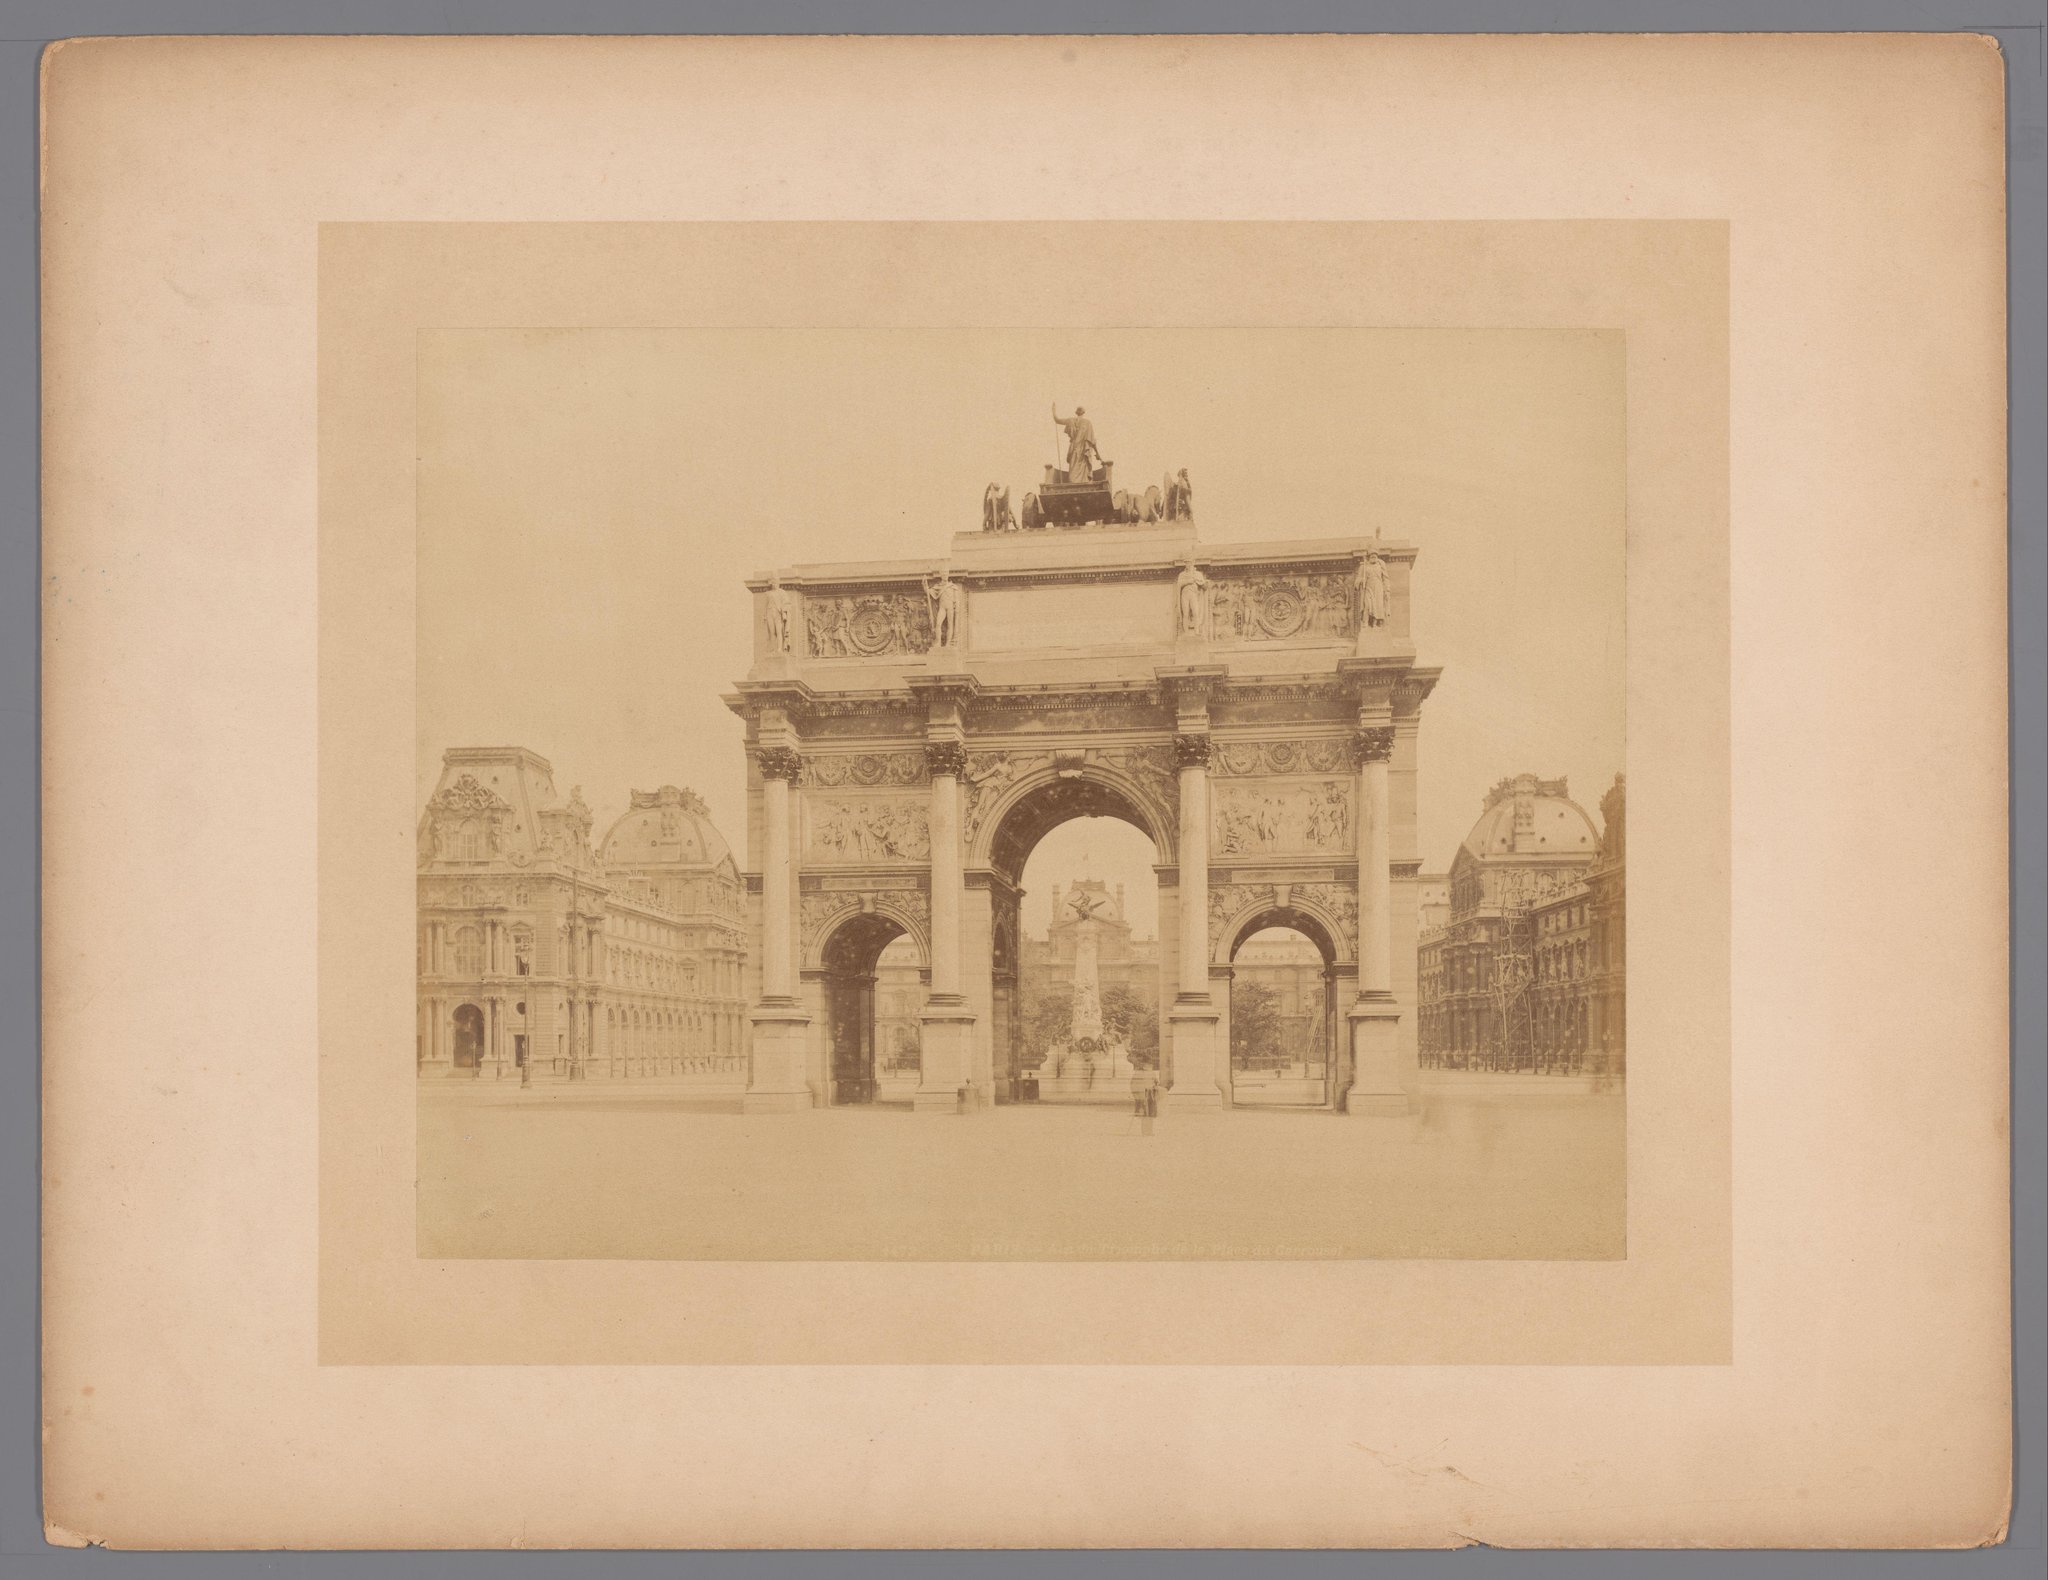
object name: photograph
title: Arc de Triomph vanuit het Place du Carrousel, Parijs, Frankrijk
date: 1870-1900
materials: cardboard, paper, photographic support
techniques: albumen print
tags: paris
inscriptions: inscription: ‘1472 PARIS - Arc de Triomphe de la Place du Carrousel’, number: ‘7.’, inscription: ‘X. Phot. [?]’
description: Arc de Triomph vanuit het Place du Carrousel, Parijs, Frankrijk.